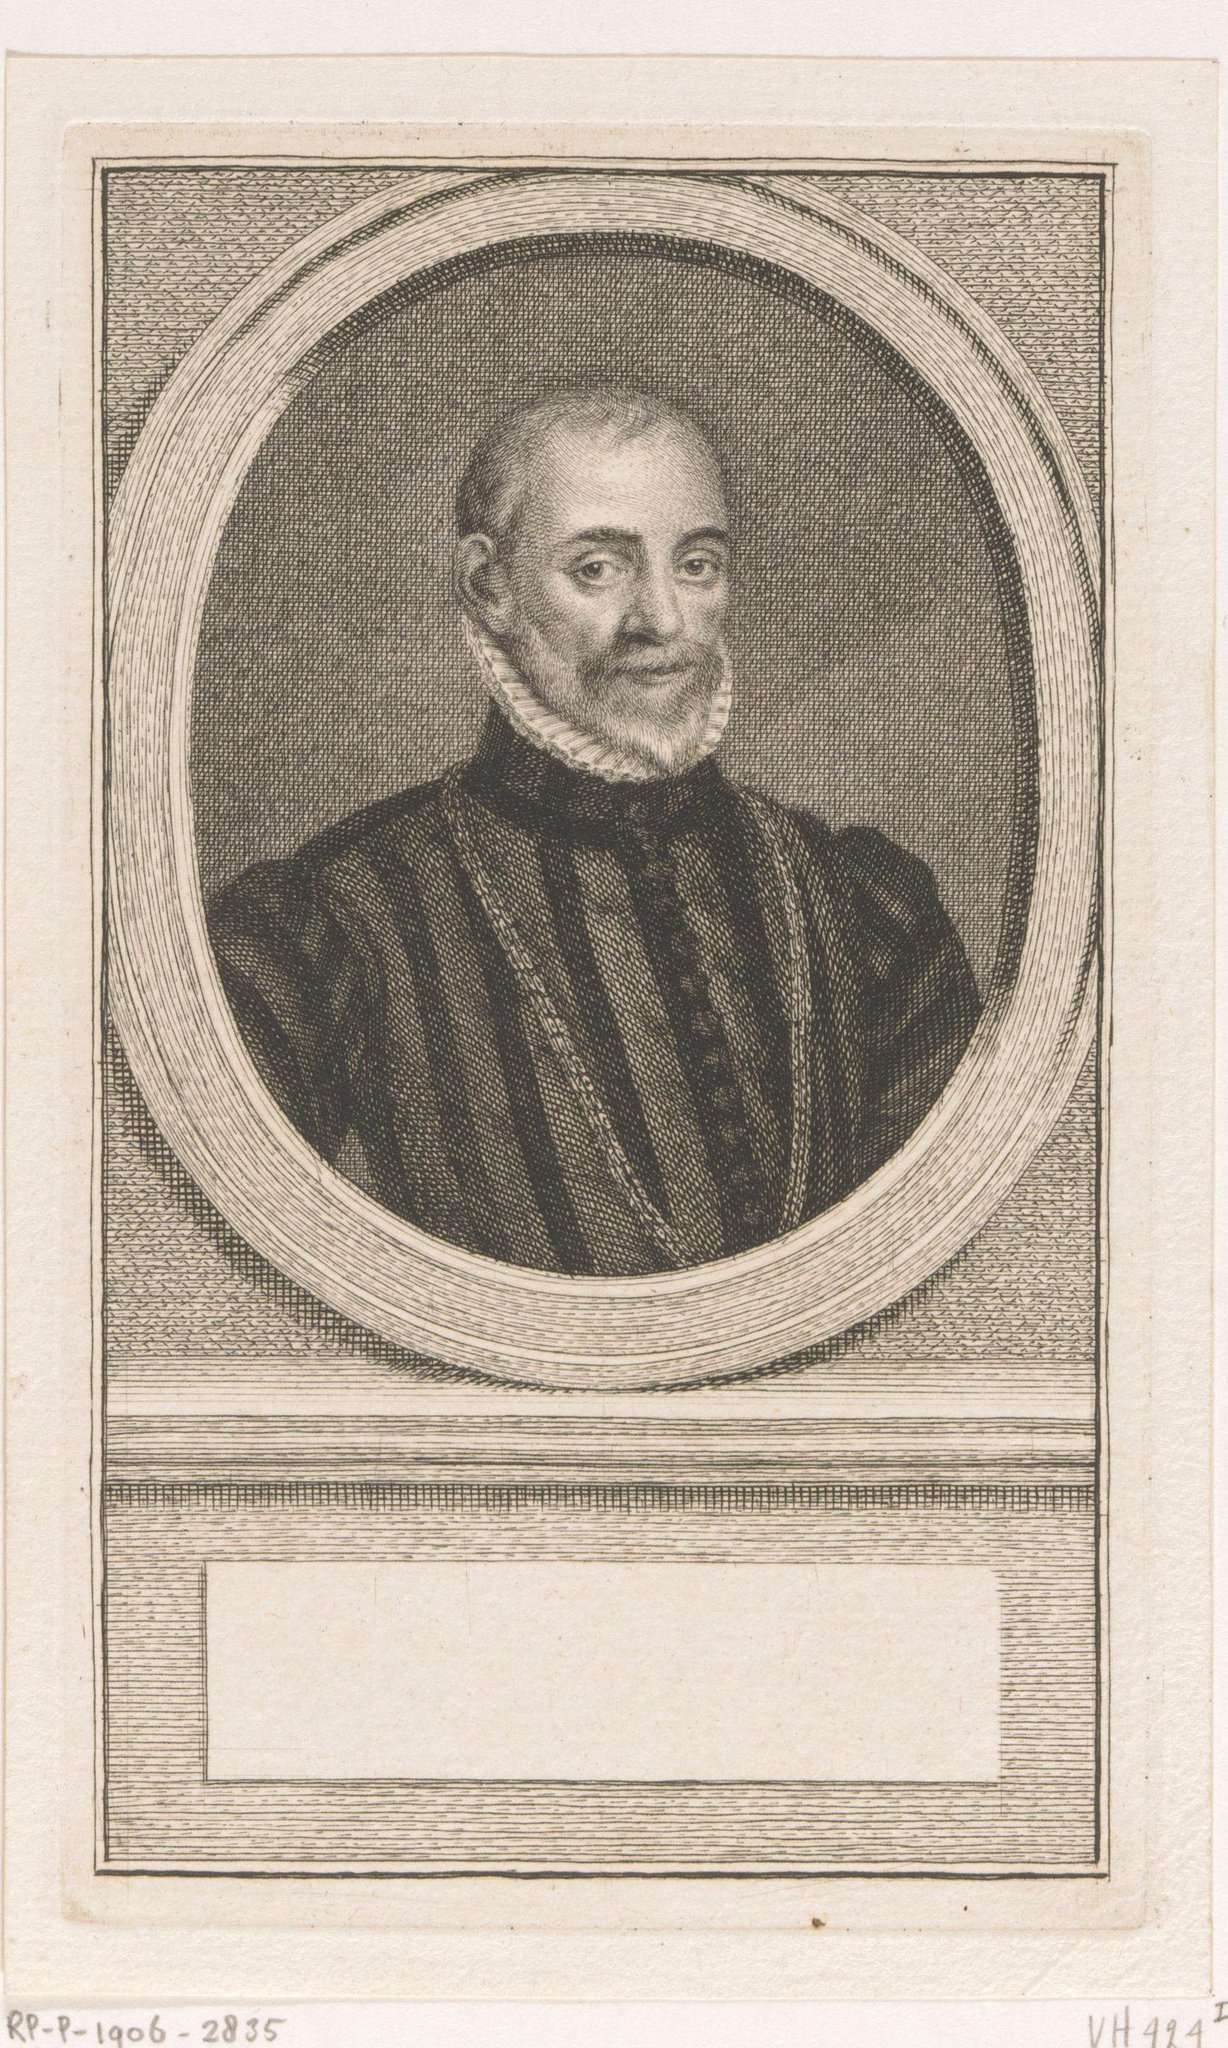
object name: print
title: Portret van Francisco de Valdez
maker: jacob houbraken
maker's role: draughtsman, print maker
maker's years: 1698-1780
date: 1775-1777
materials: paper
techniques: engraving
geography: amsterdam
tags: veldheer, francisco de valdez, beleg van leiden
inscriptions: collector's mark: Lugt 2228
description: Proefdruk van de prent volgens Ver Huell gebruitk in: Adrianus Severinus, Oorspronckelijke beschrijving van de vermaerde belegering en 't ontzet der stad Leiden. Leiden: wed. A. Honkoop en zoon, vijfde editie, 1777.